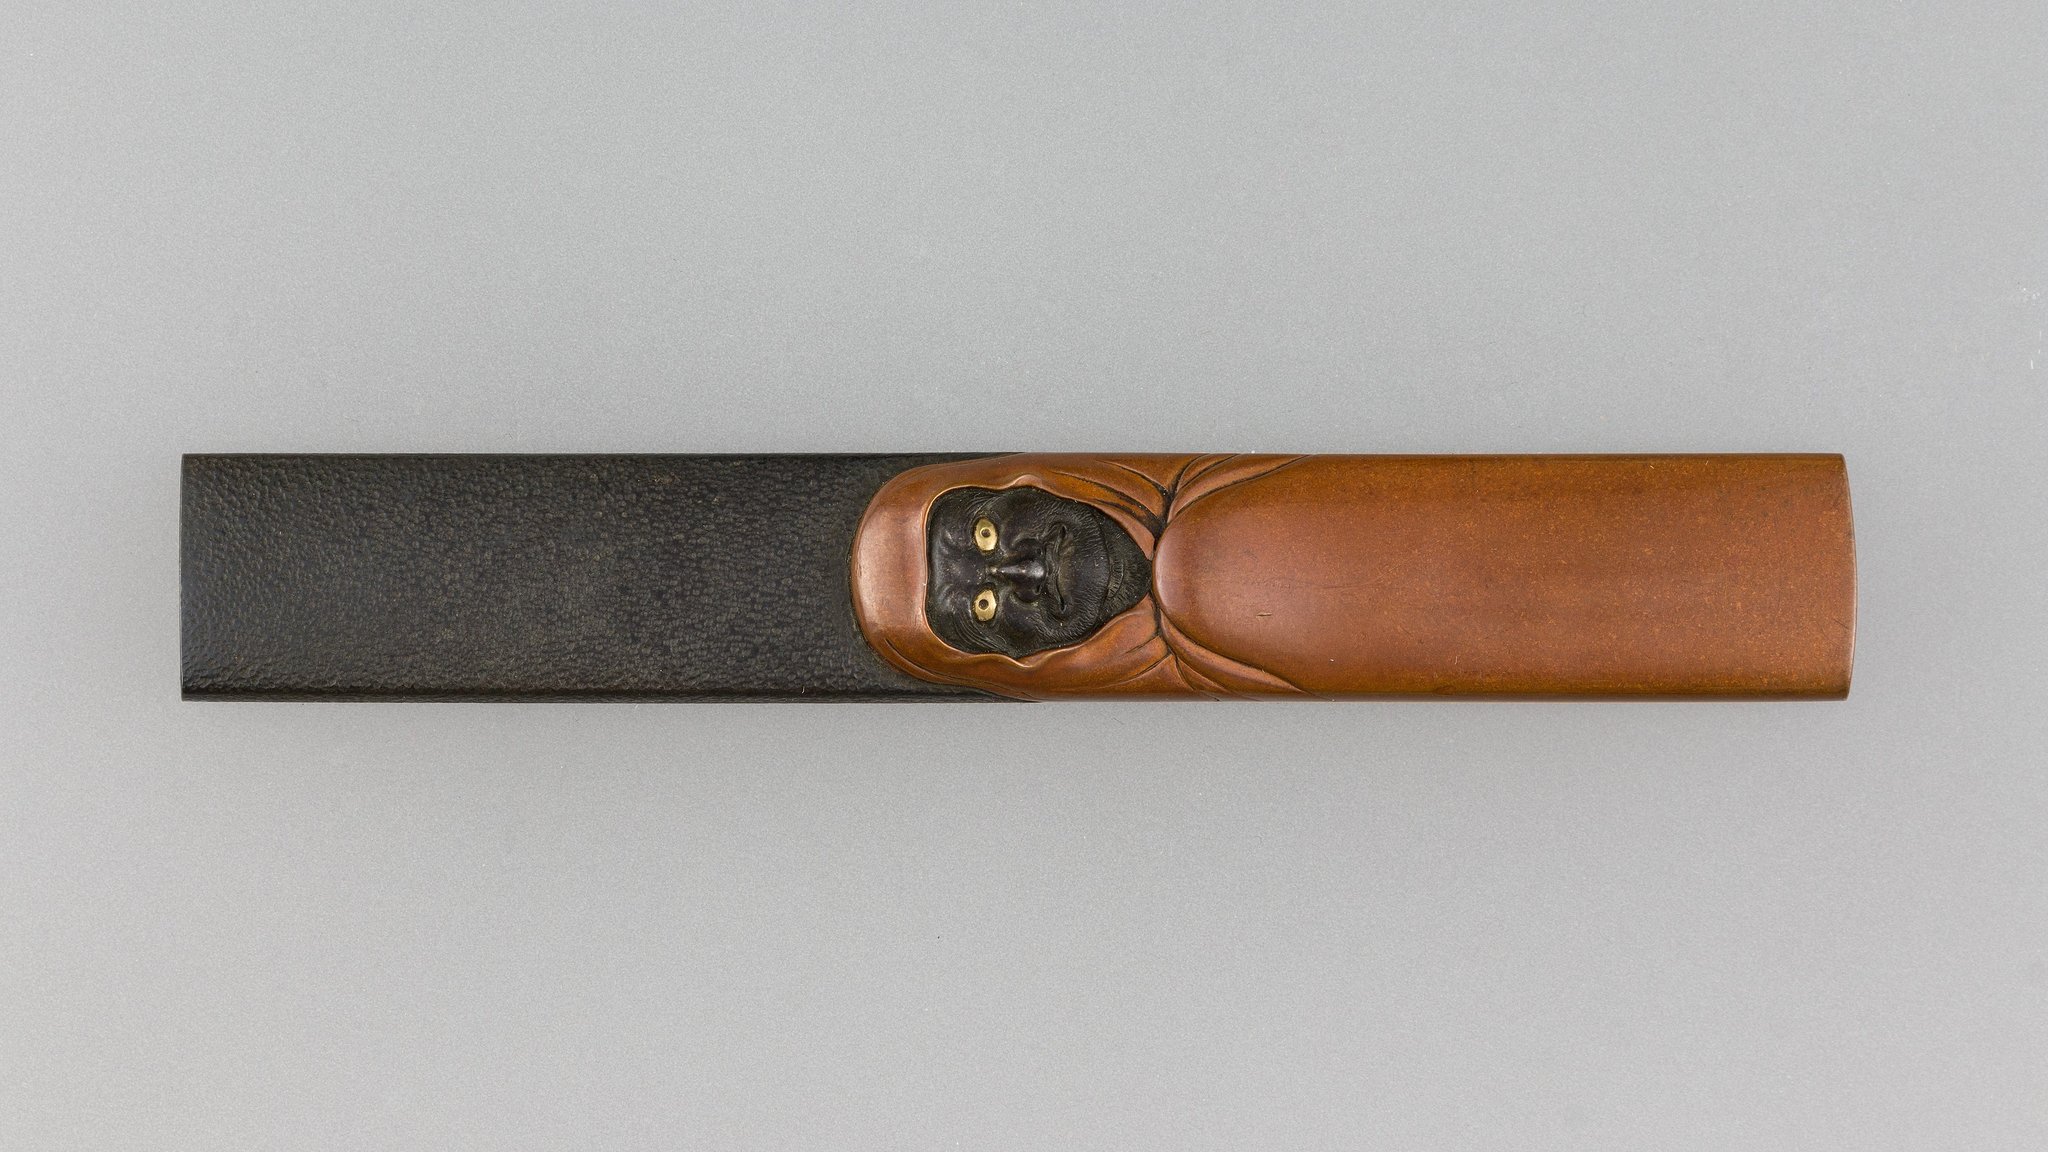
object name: knife handle kozuka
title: Knife Handle (Kozuka)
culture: japanese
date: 1801-1900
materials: copper, silver alloy, gold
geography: japan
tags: men